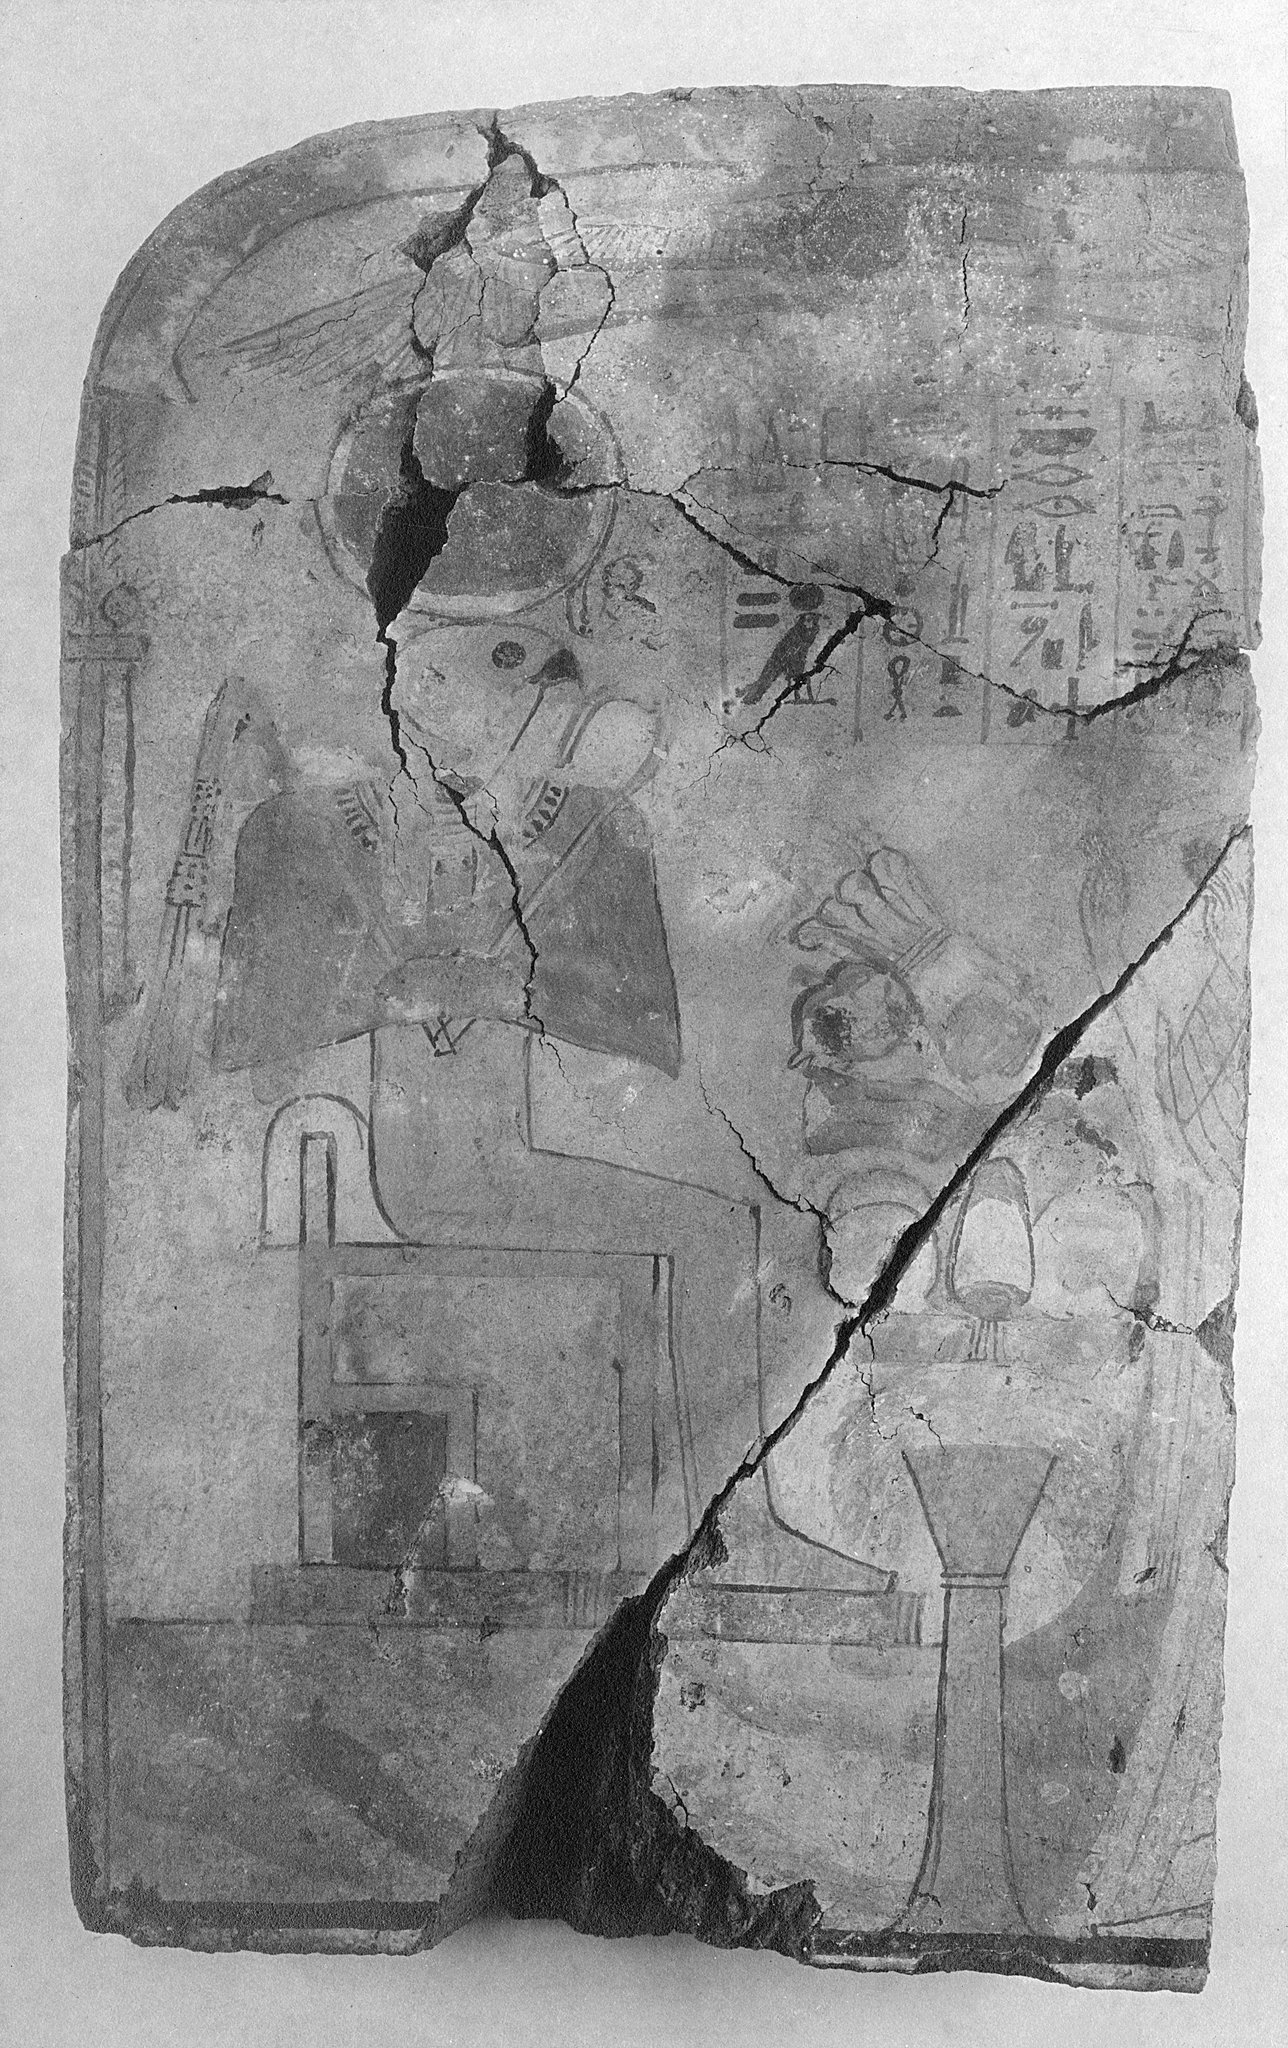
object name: stela with a seated figure of re harakhty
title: Stela with a seated figure of Re-Harakhty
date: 1070-712 BCE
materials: paint, wood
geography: egypt